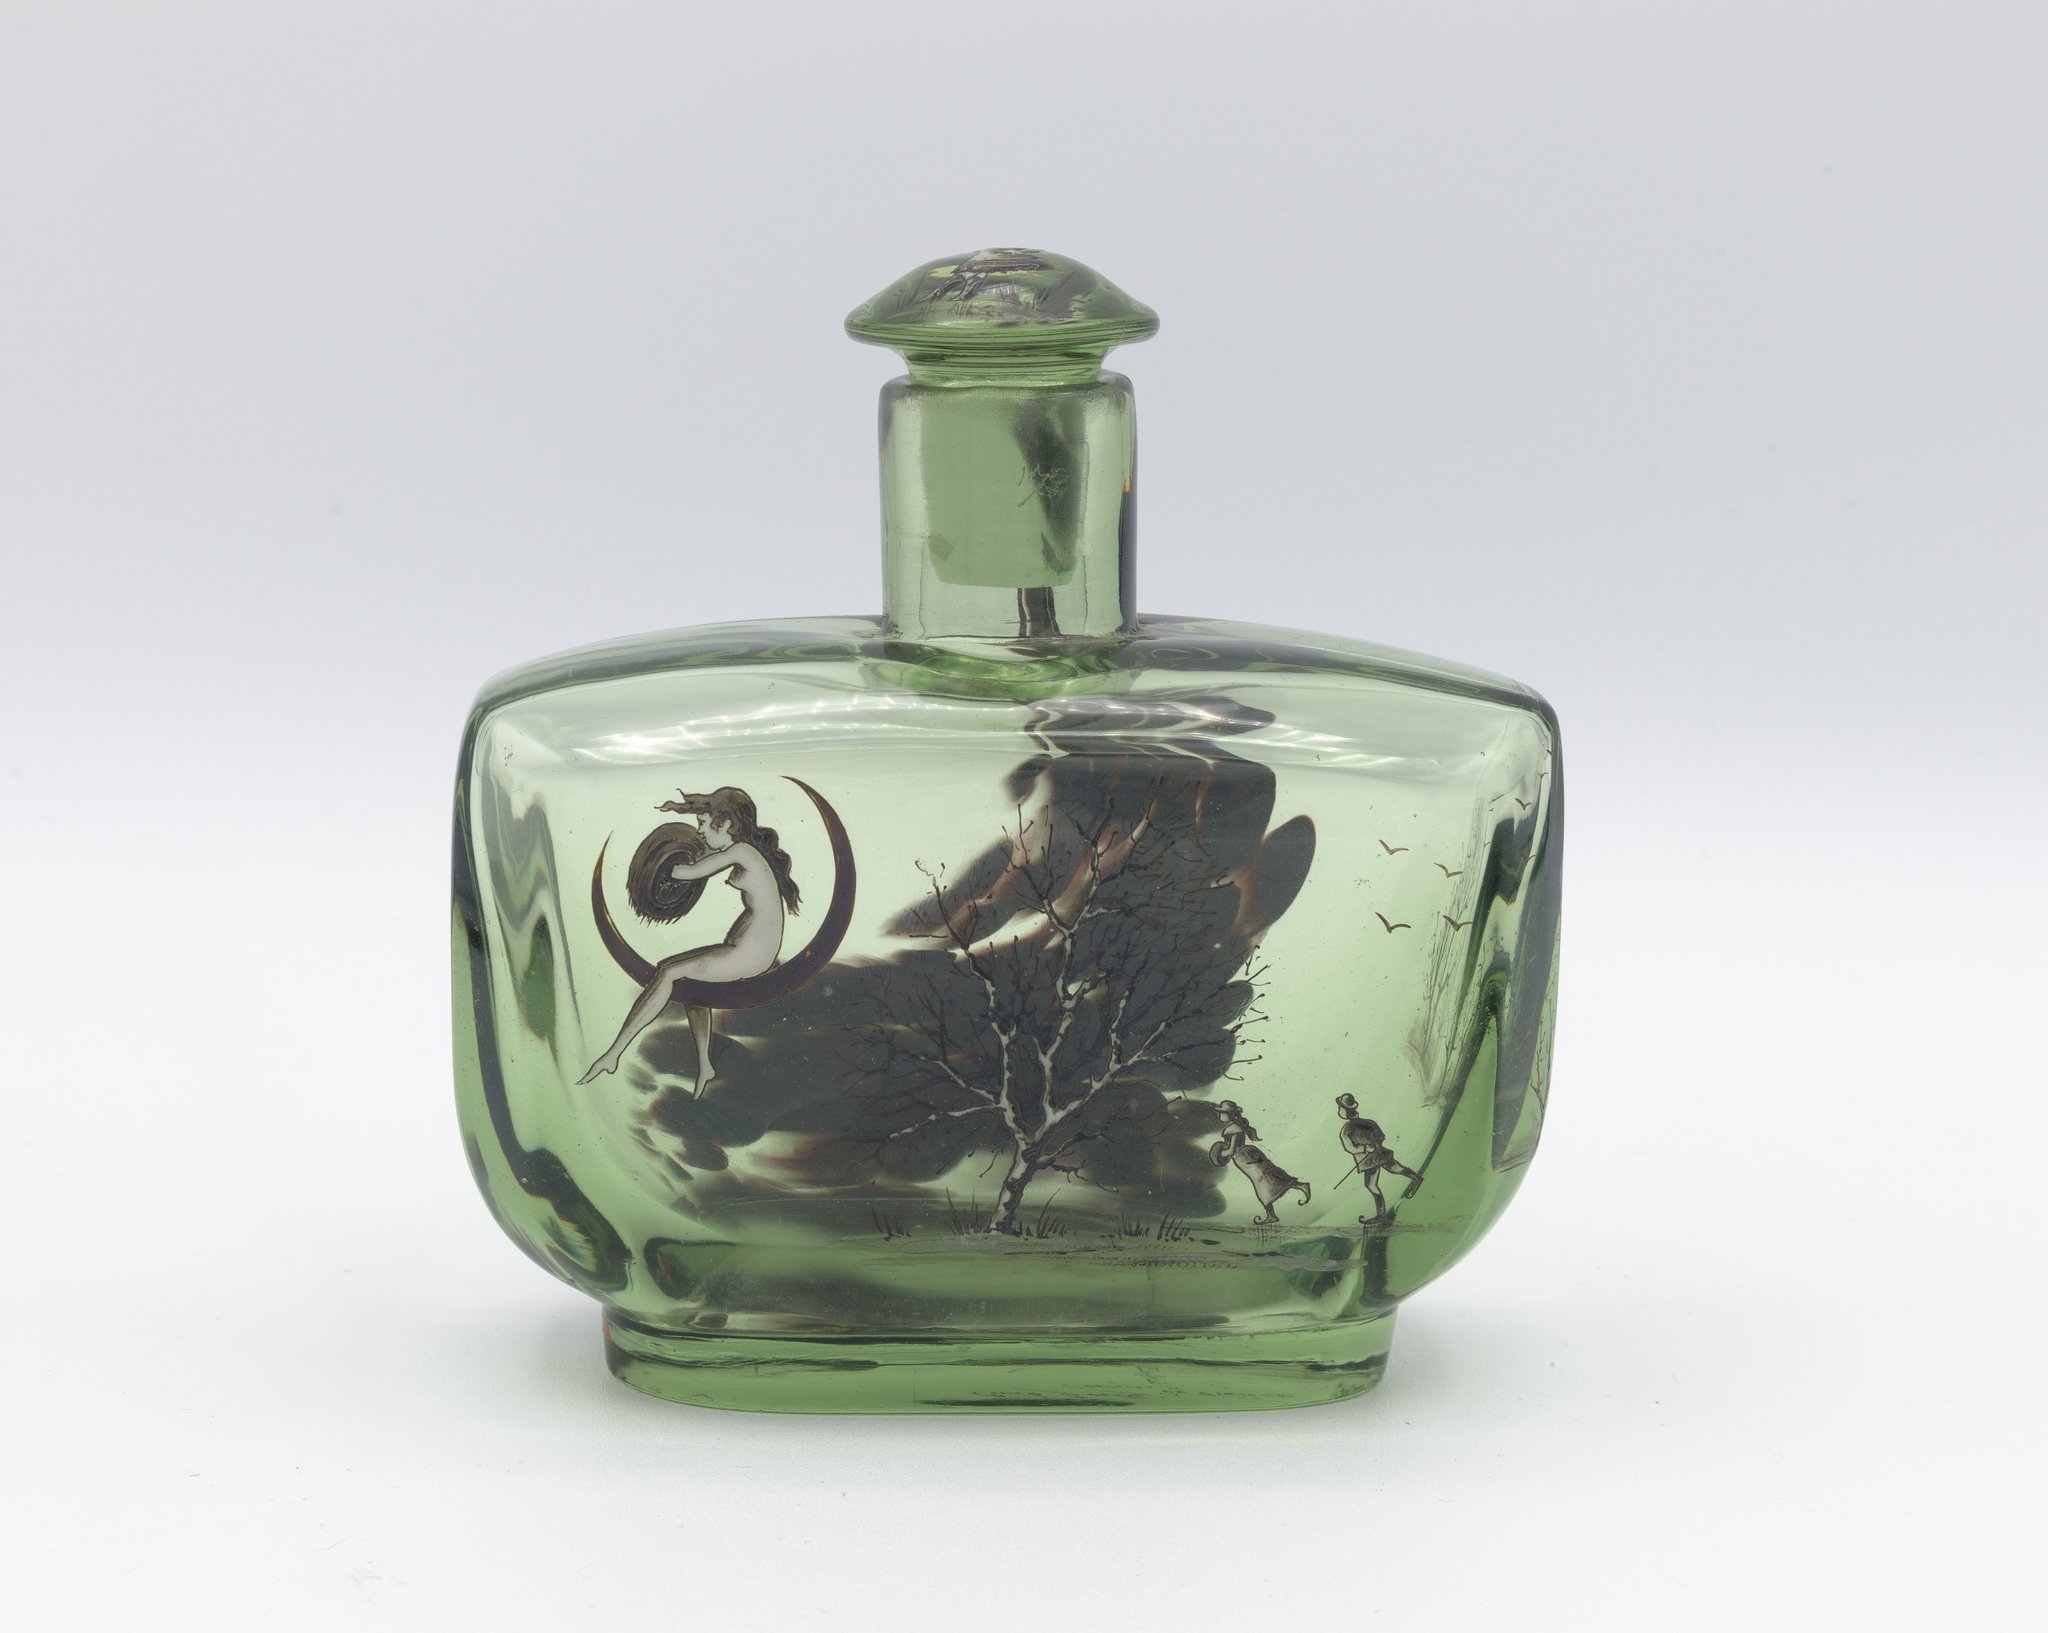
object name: bottle with stopper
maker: emile gallé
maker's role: designer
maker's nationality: french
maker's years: 1846-1904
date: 1880-1890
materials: glass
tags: female nudes,moon